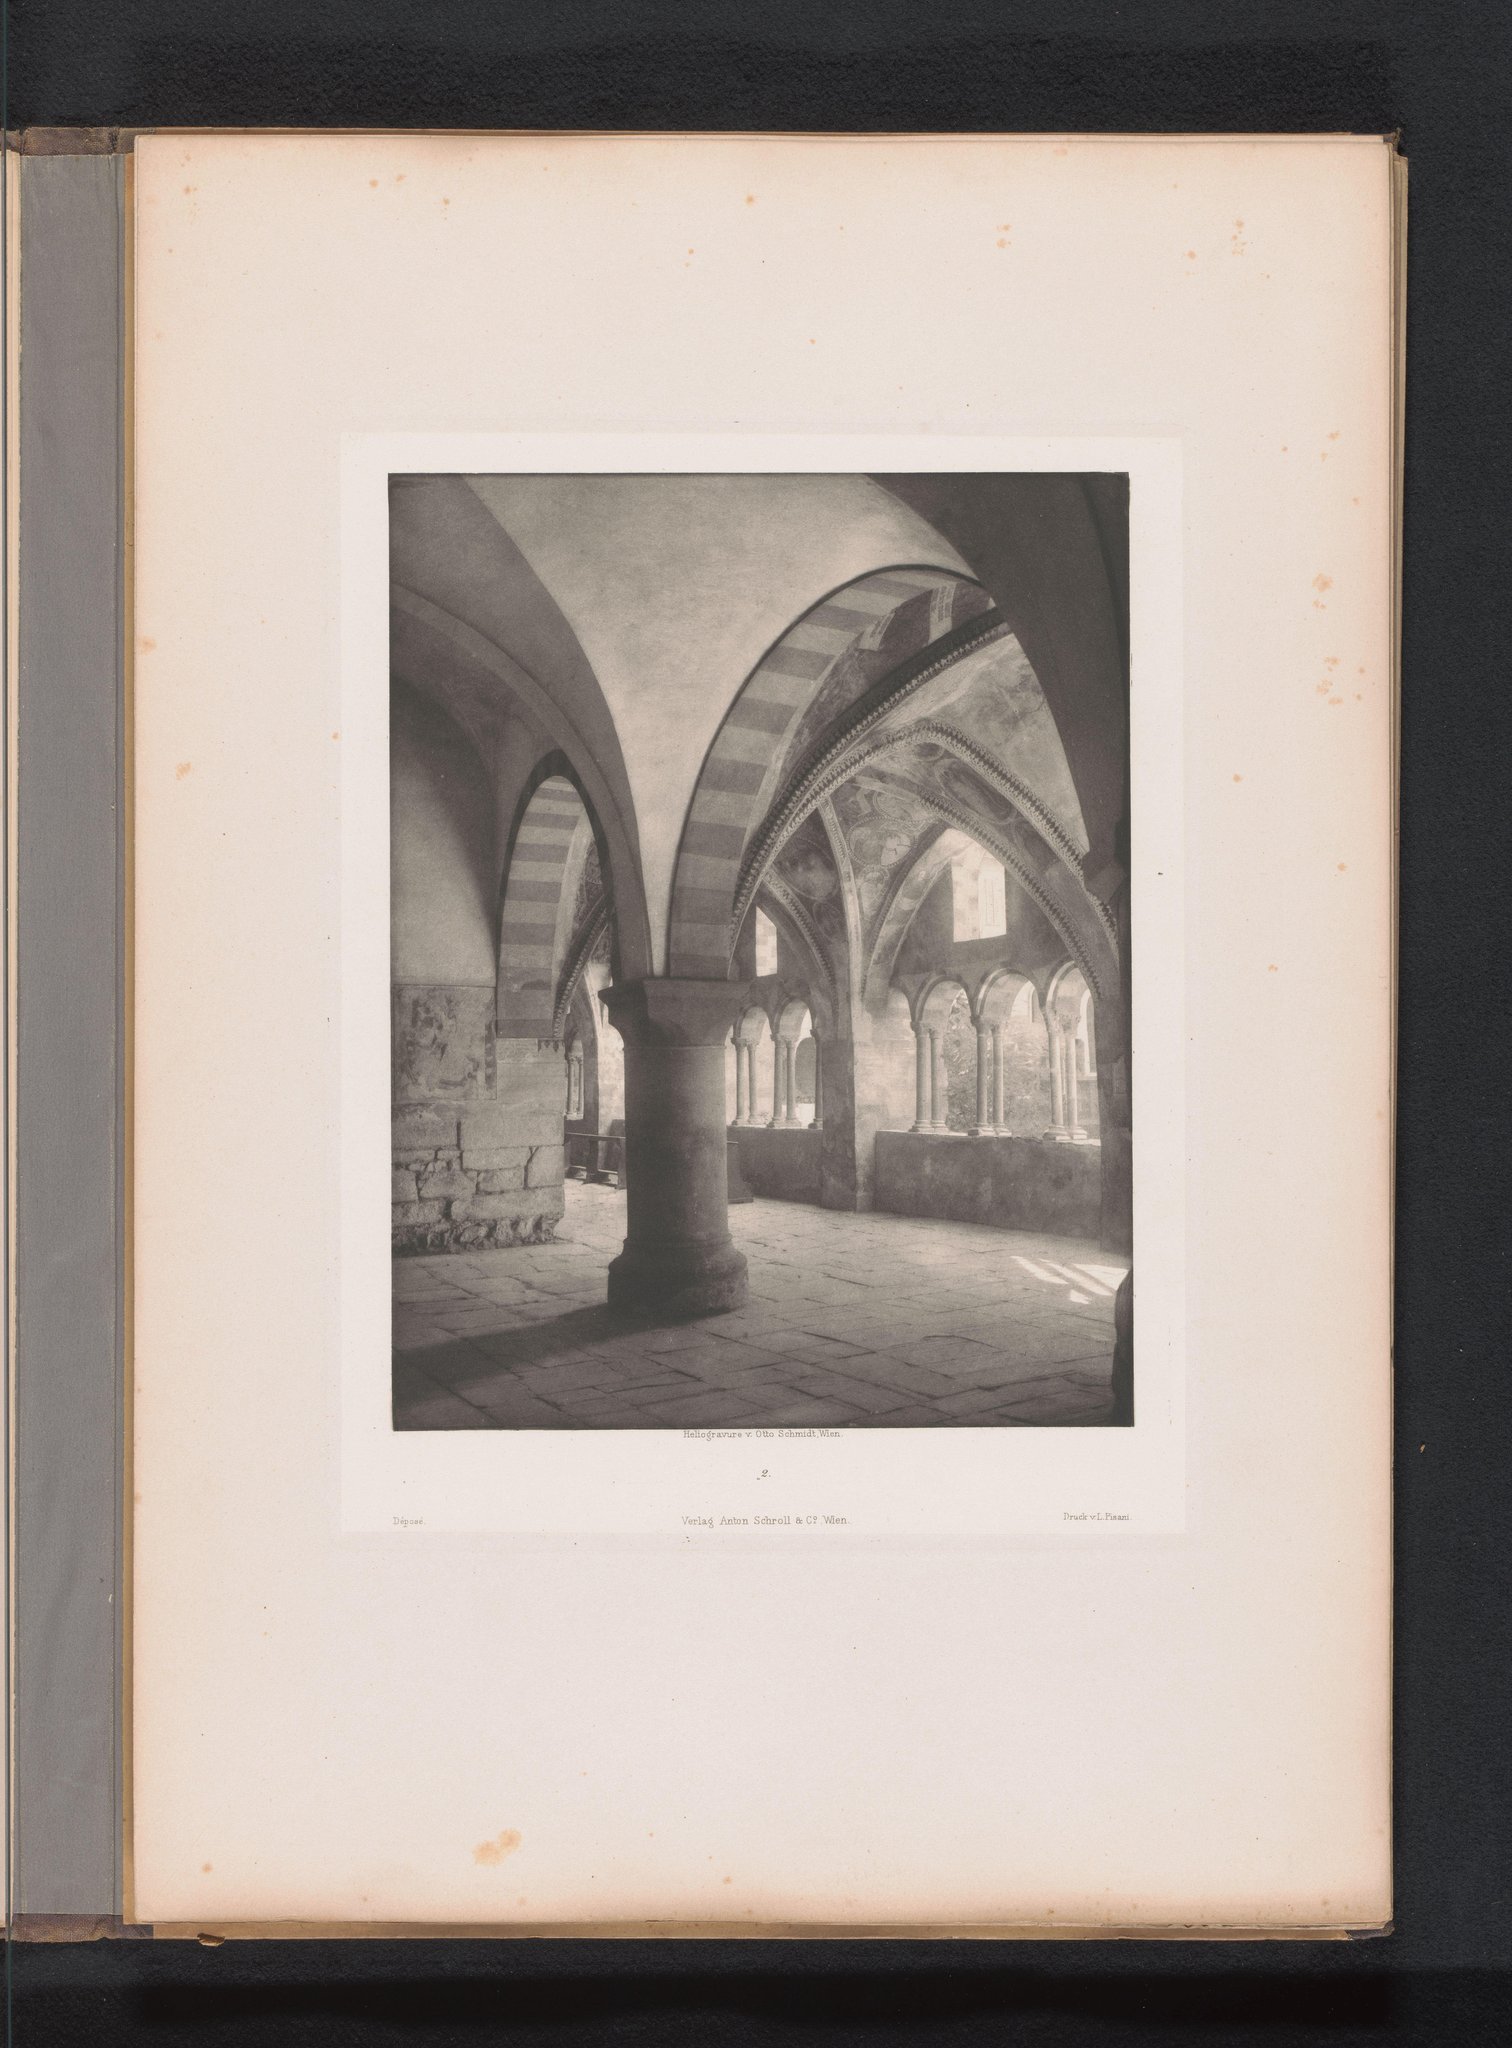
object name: photomechanical print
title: Gezicht op een kruisgang met fresco's in Bressanone, Italië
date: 1886-1891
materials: paper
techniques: photoaquatint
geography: bressanone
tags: interior of church, picture, painting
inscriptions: inscription: ‘Déposé.’, number: ‘2.’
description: Deze prent maakt deel uit van een omslag met dertig prenten en drie tekstbladen.